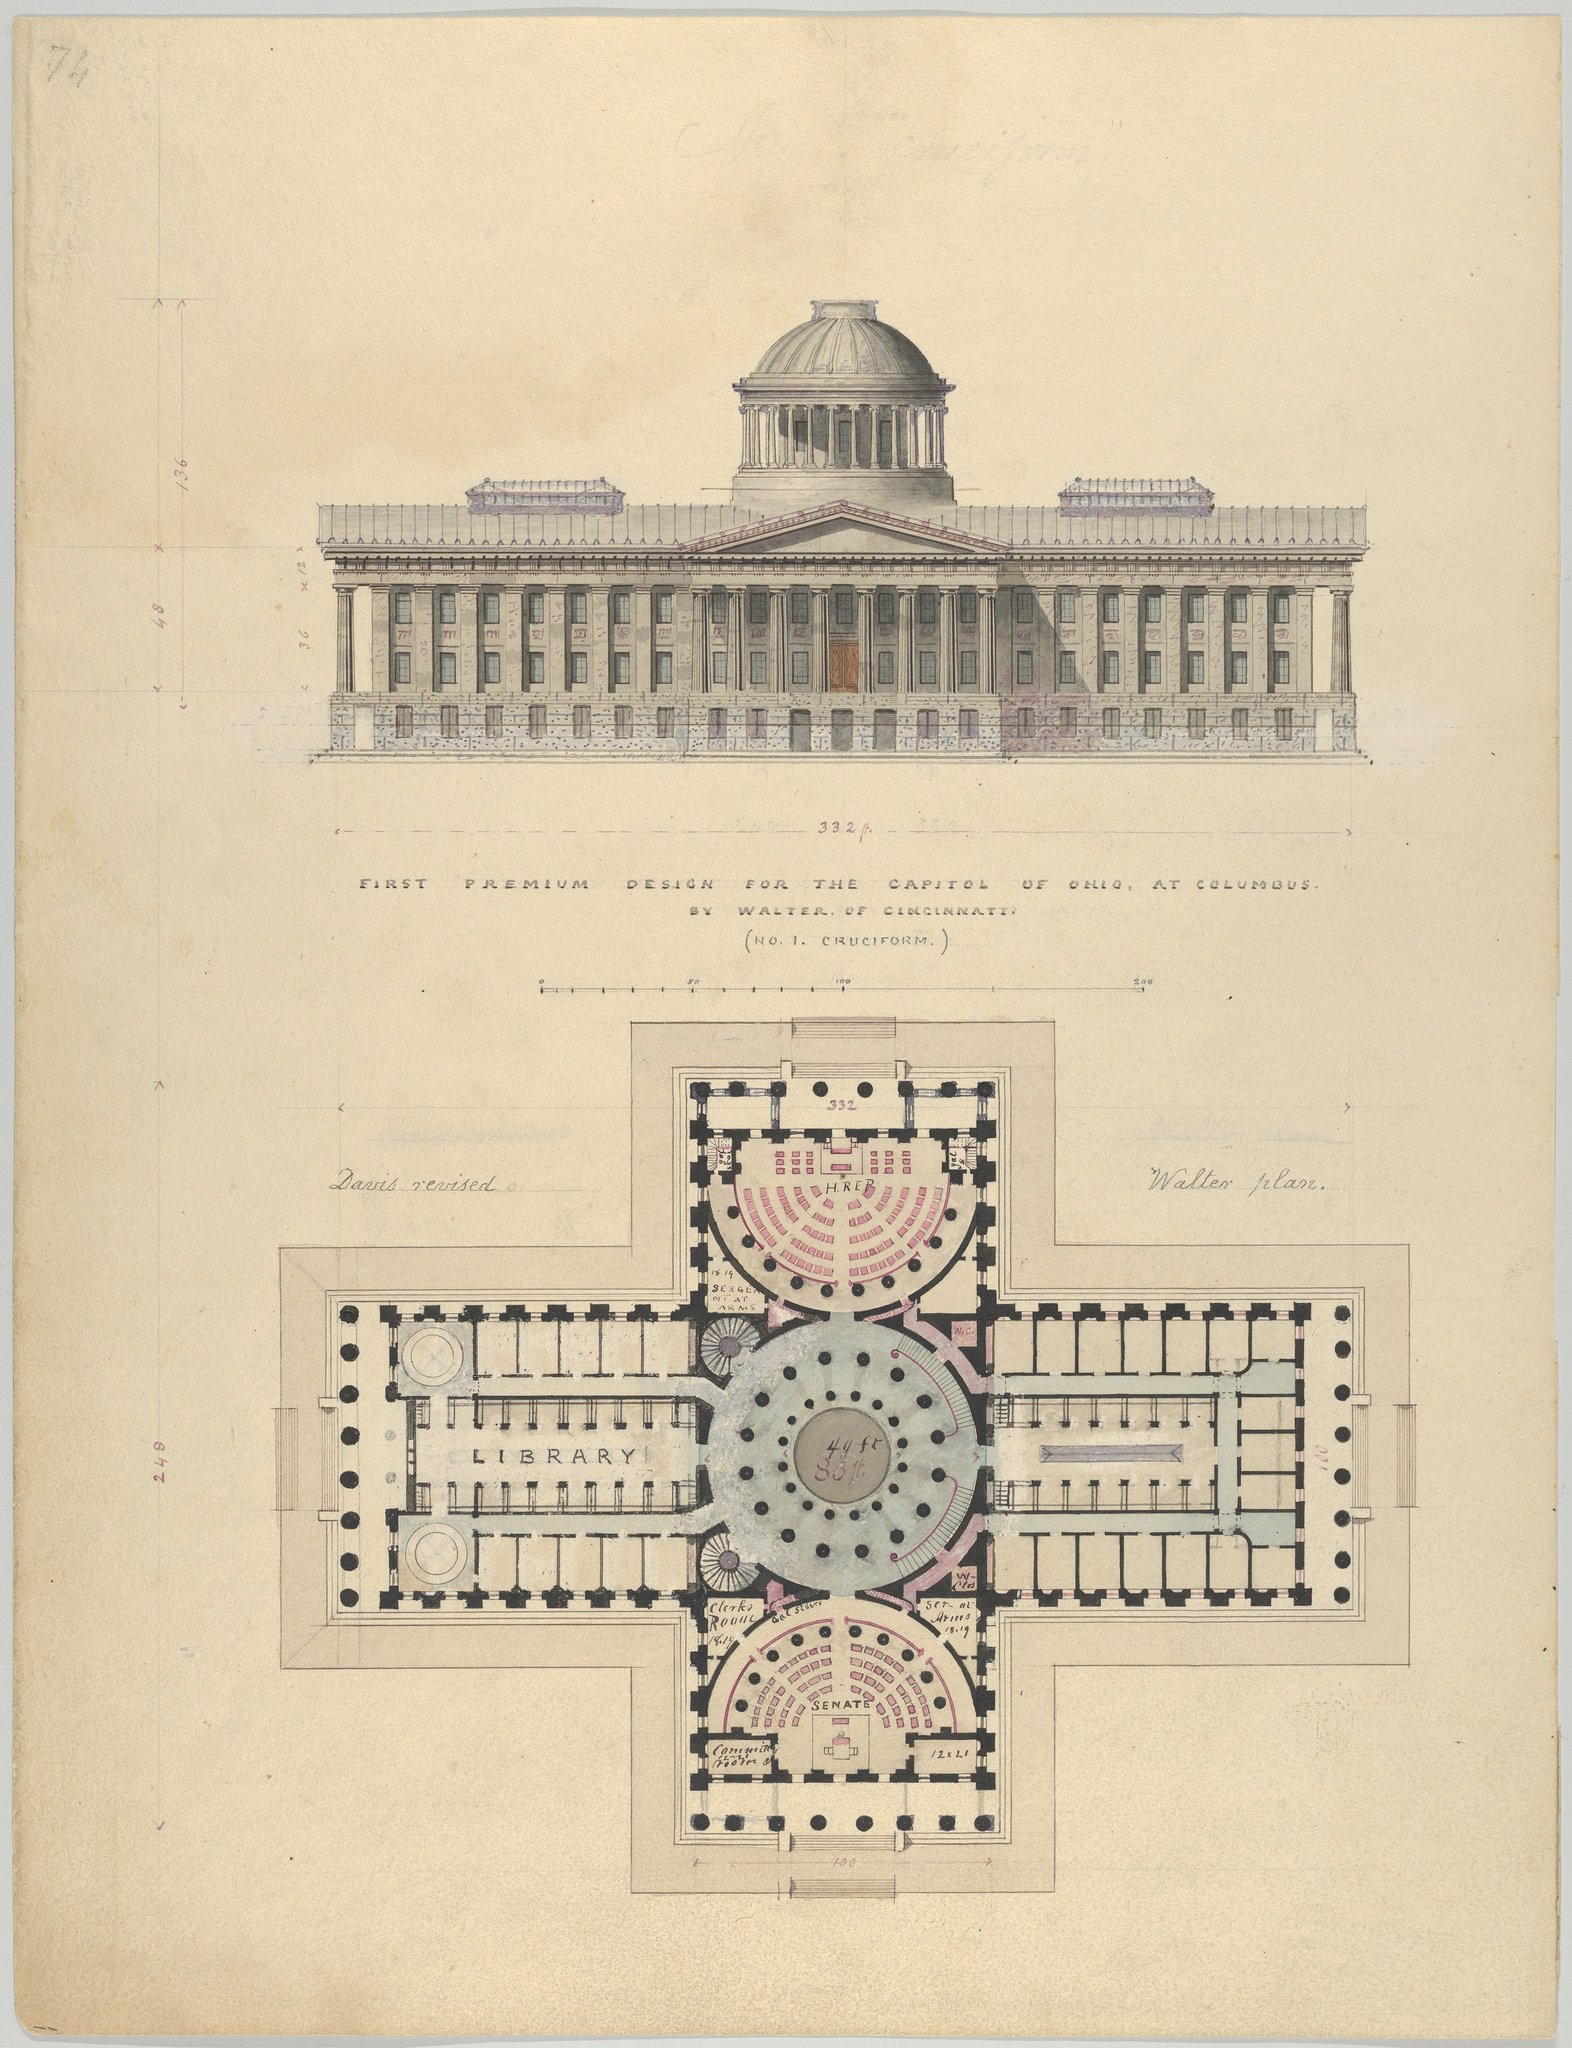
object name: drawing ornament architecture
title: First Premium Design for the Capitol of Ohio at Columbus by Walter of Cincinnati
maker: alexander jackson davis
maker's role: artist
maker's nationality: american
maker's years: 1803-1892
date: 1839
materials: graphite, ink, watercolor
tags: architecture,buildings